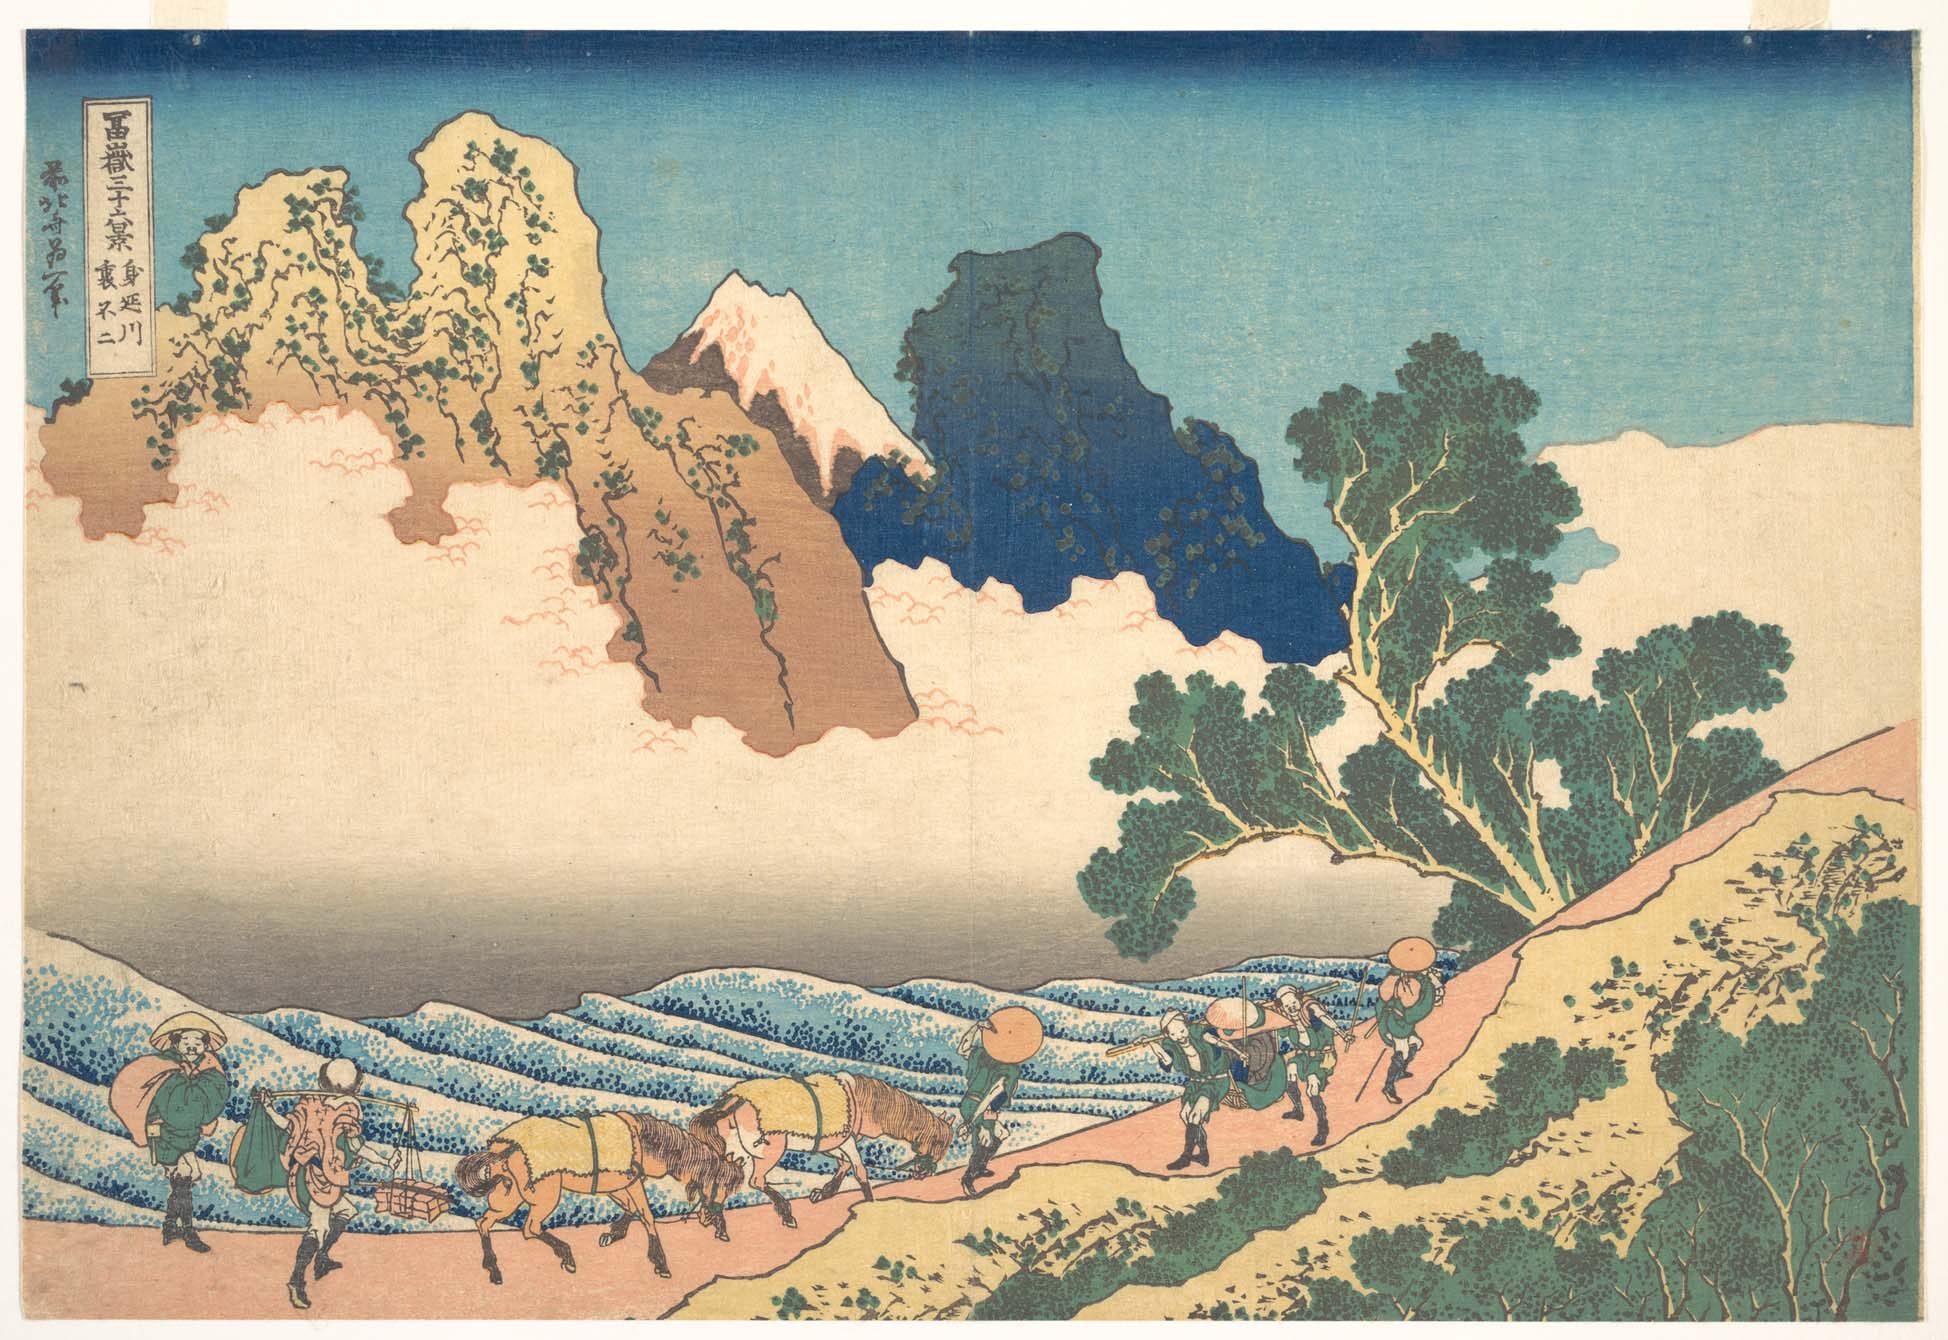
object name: woodblock print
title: View from the Other Side of Fuji from the Minobu River (Minobugawa ura Fuji), from the series Thirty-six Views of Mount Fuji (Fugaku sanjūrokkei)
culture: japanese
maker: katsushika hokusai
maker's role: artist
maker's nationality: japanese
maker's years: 1760-1849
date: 1830-1832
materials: ink, paper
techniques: woodblock print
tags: men,horses,rivers,mountains,trees